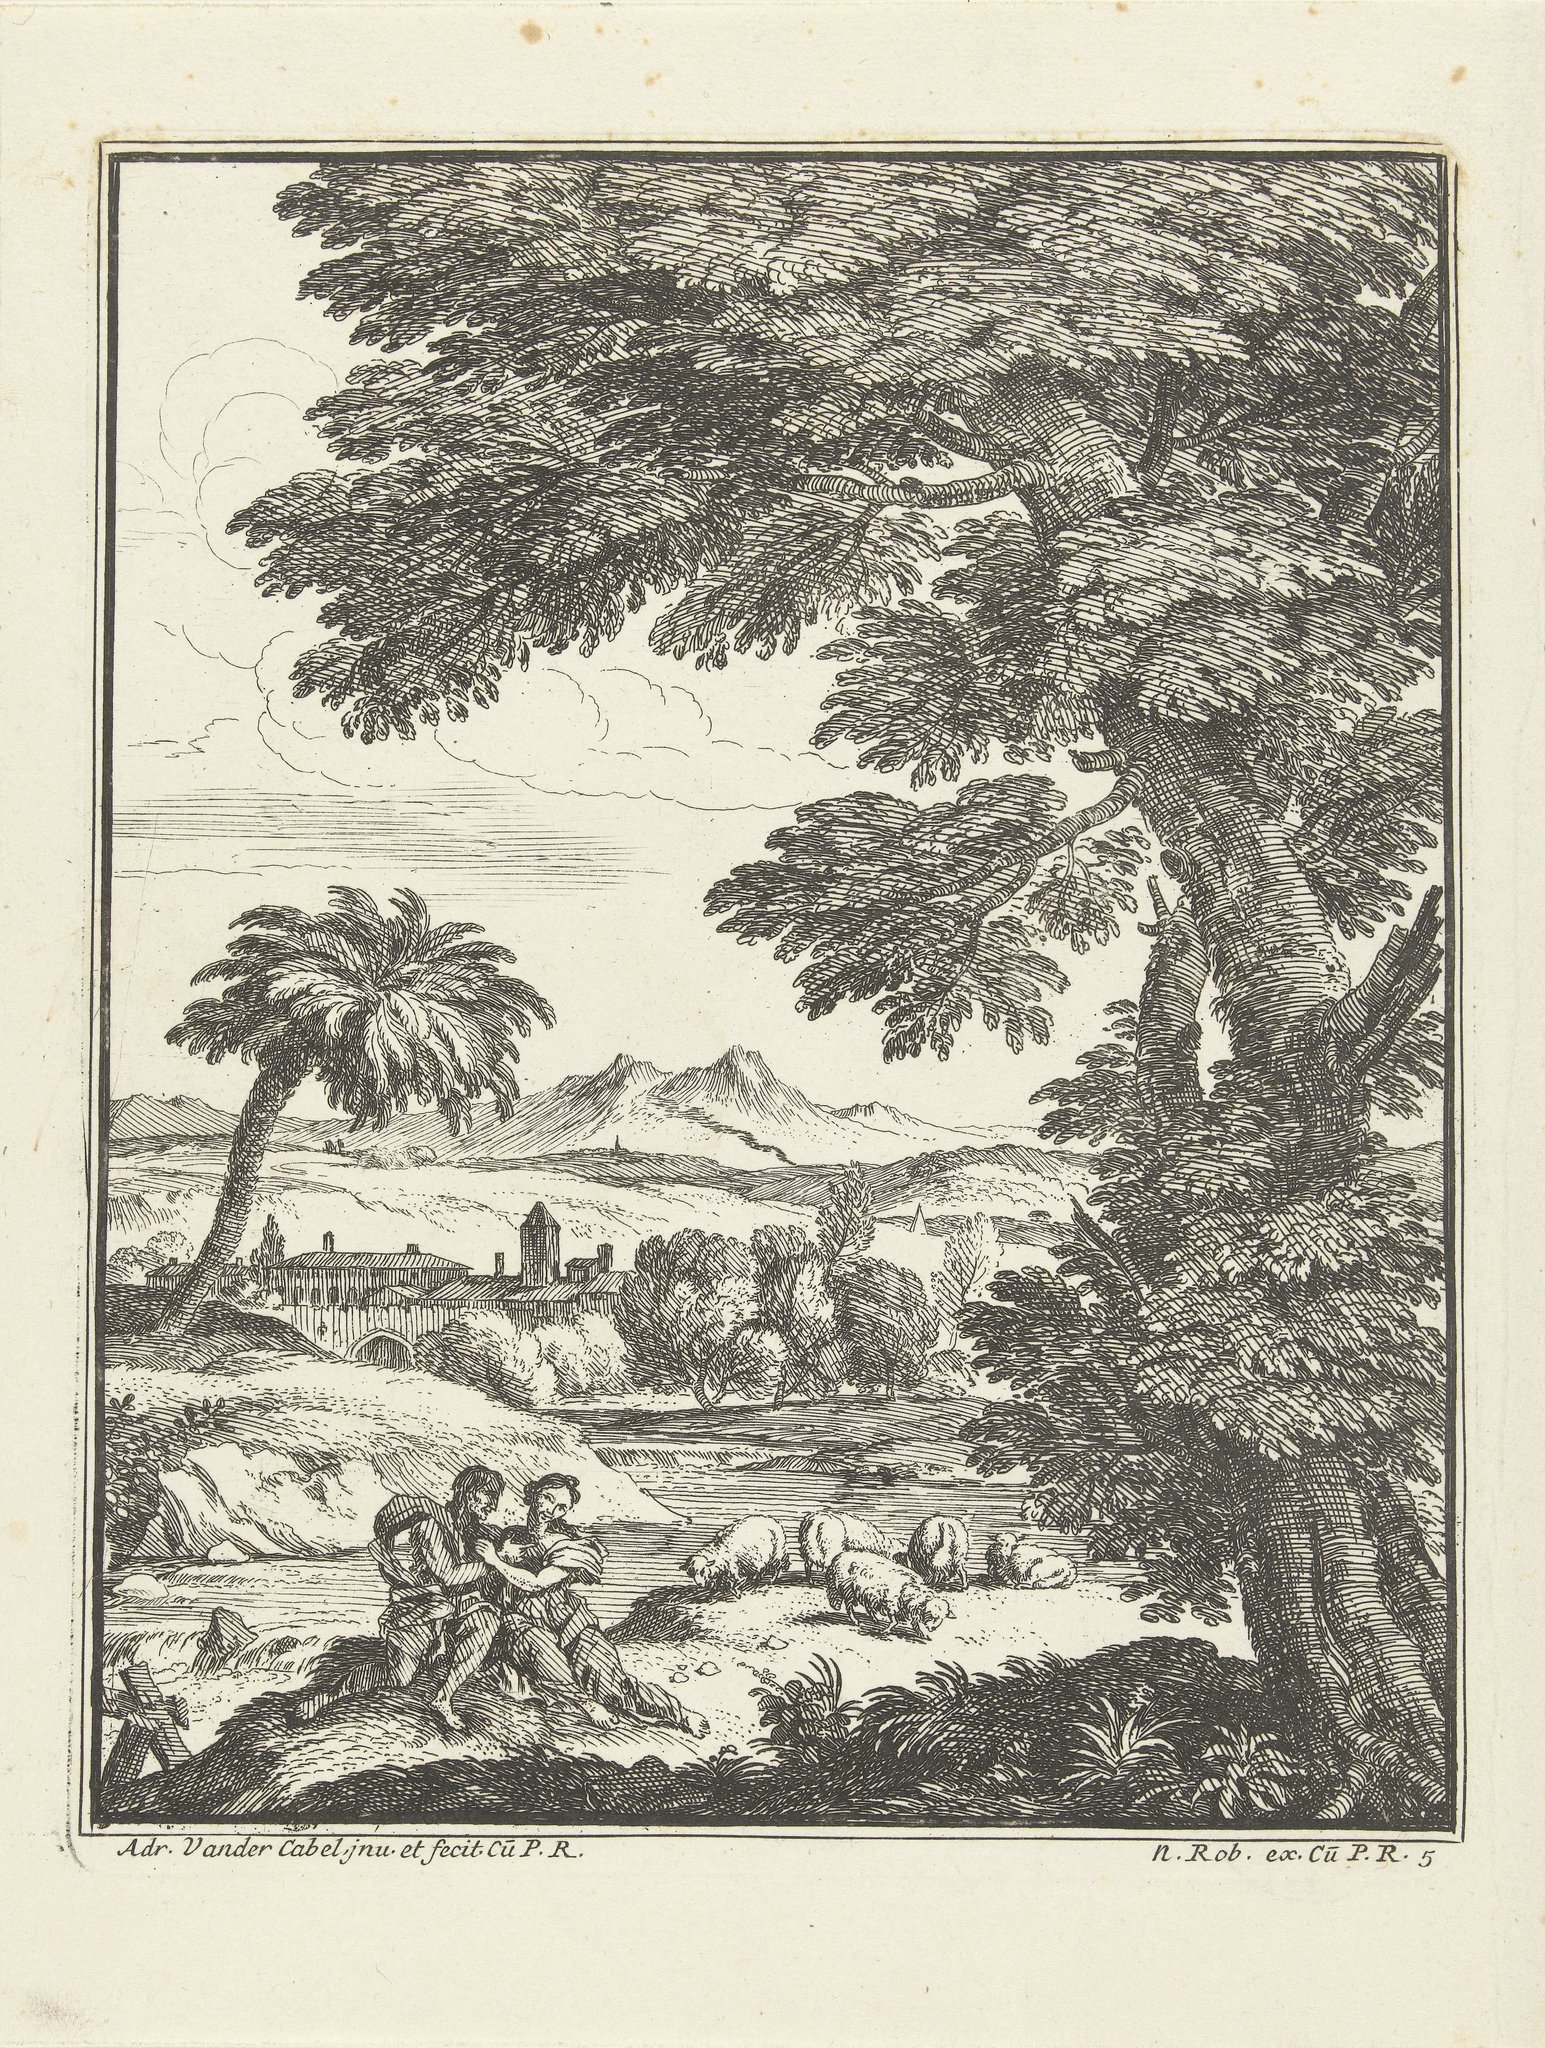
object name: print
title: Landschappen met schaapsherders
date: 1648-1705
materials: paper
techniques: etching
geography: france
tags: herding, herdsman, herdswoman, shepherd, shepherdess, cowherd, etc., the (nude) human figure; 'corpo humano' (ripa) (+ caressing, courting, making love)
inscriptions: collector's mark: Lugt 240